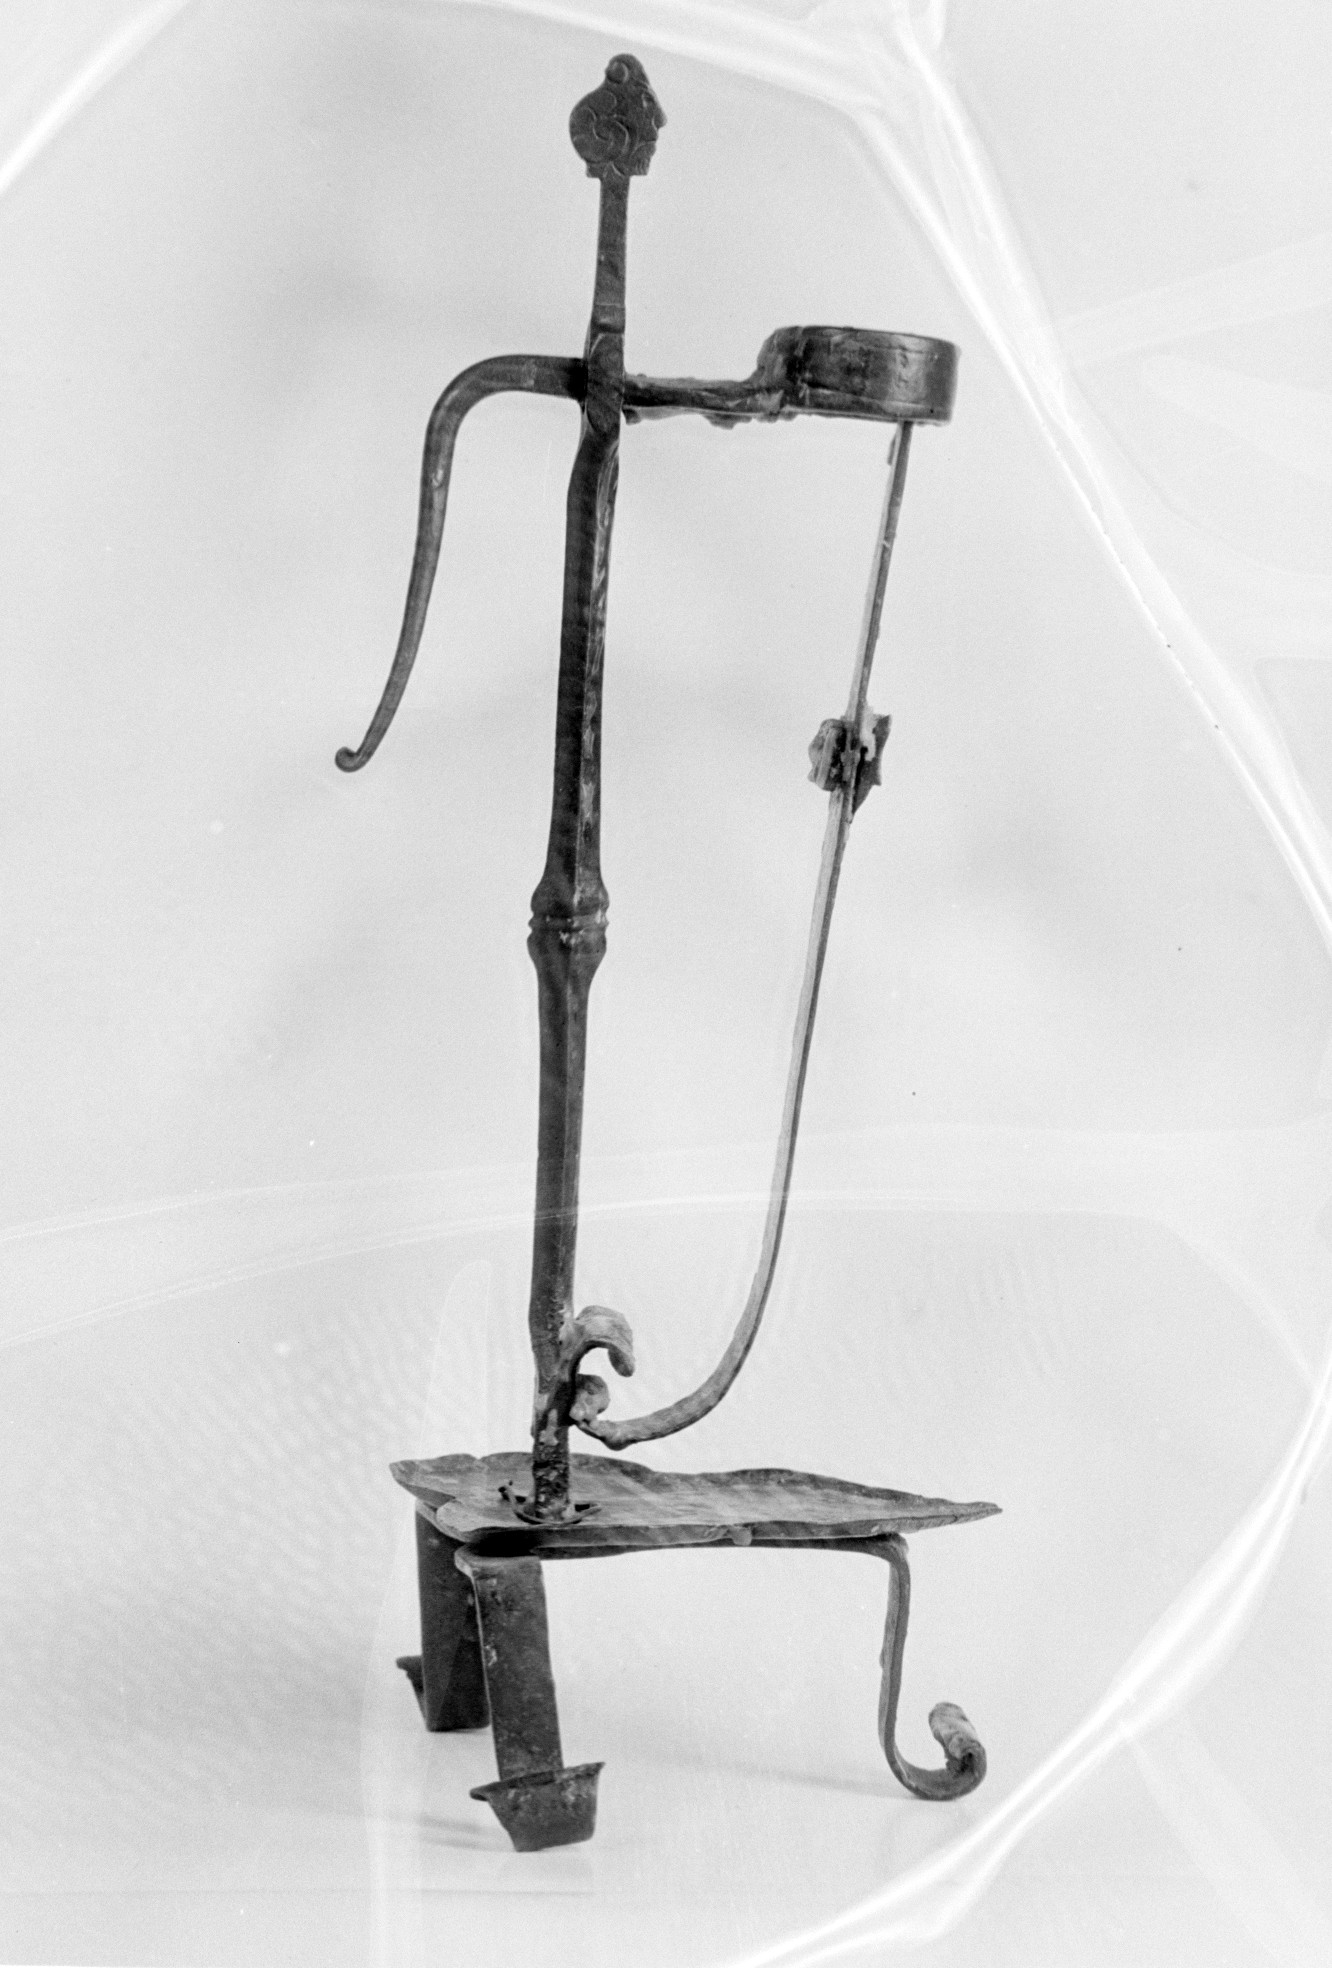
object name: candlestick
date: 1501-1600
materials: iron